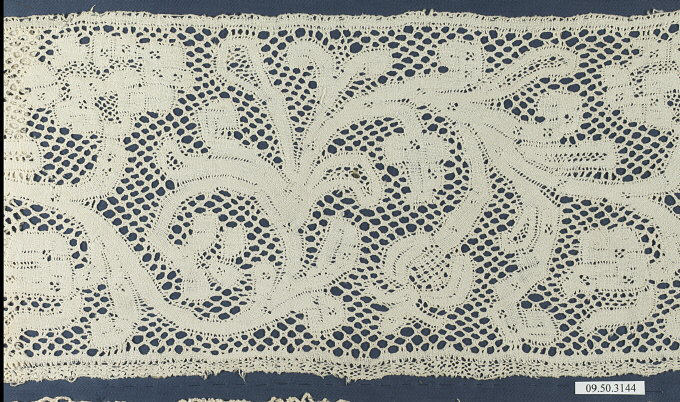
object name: strip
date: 1601-1800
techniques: lace